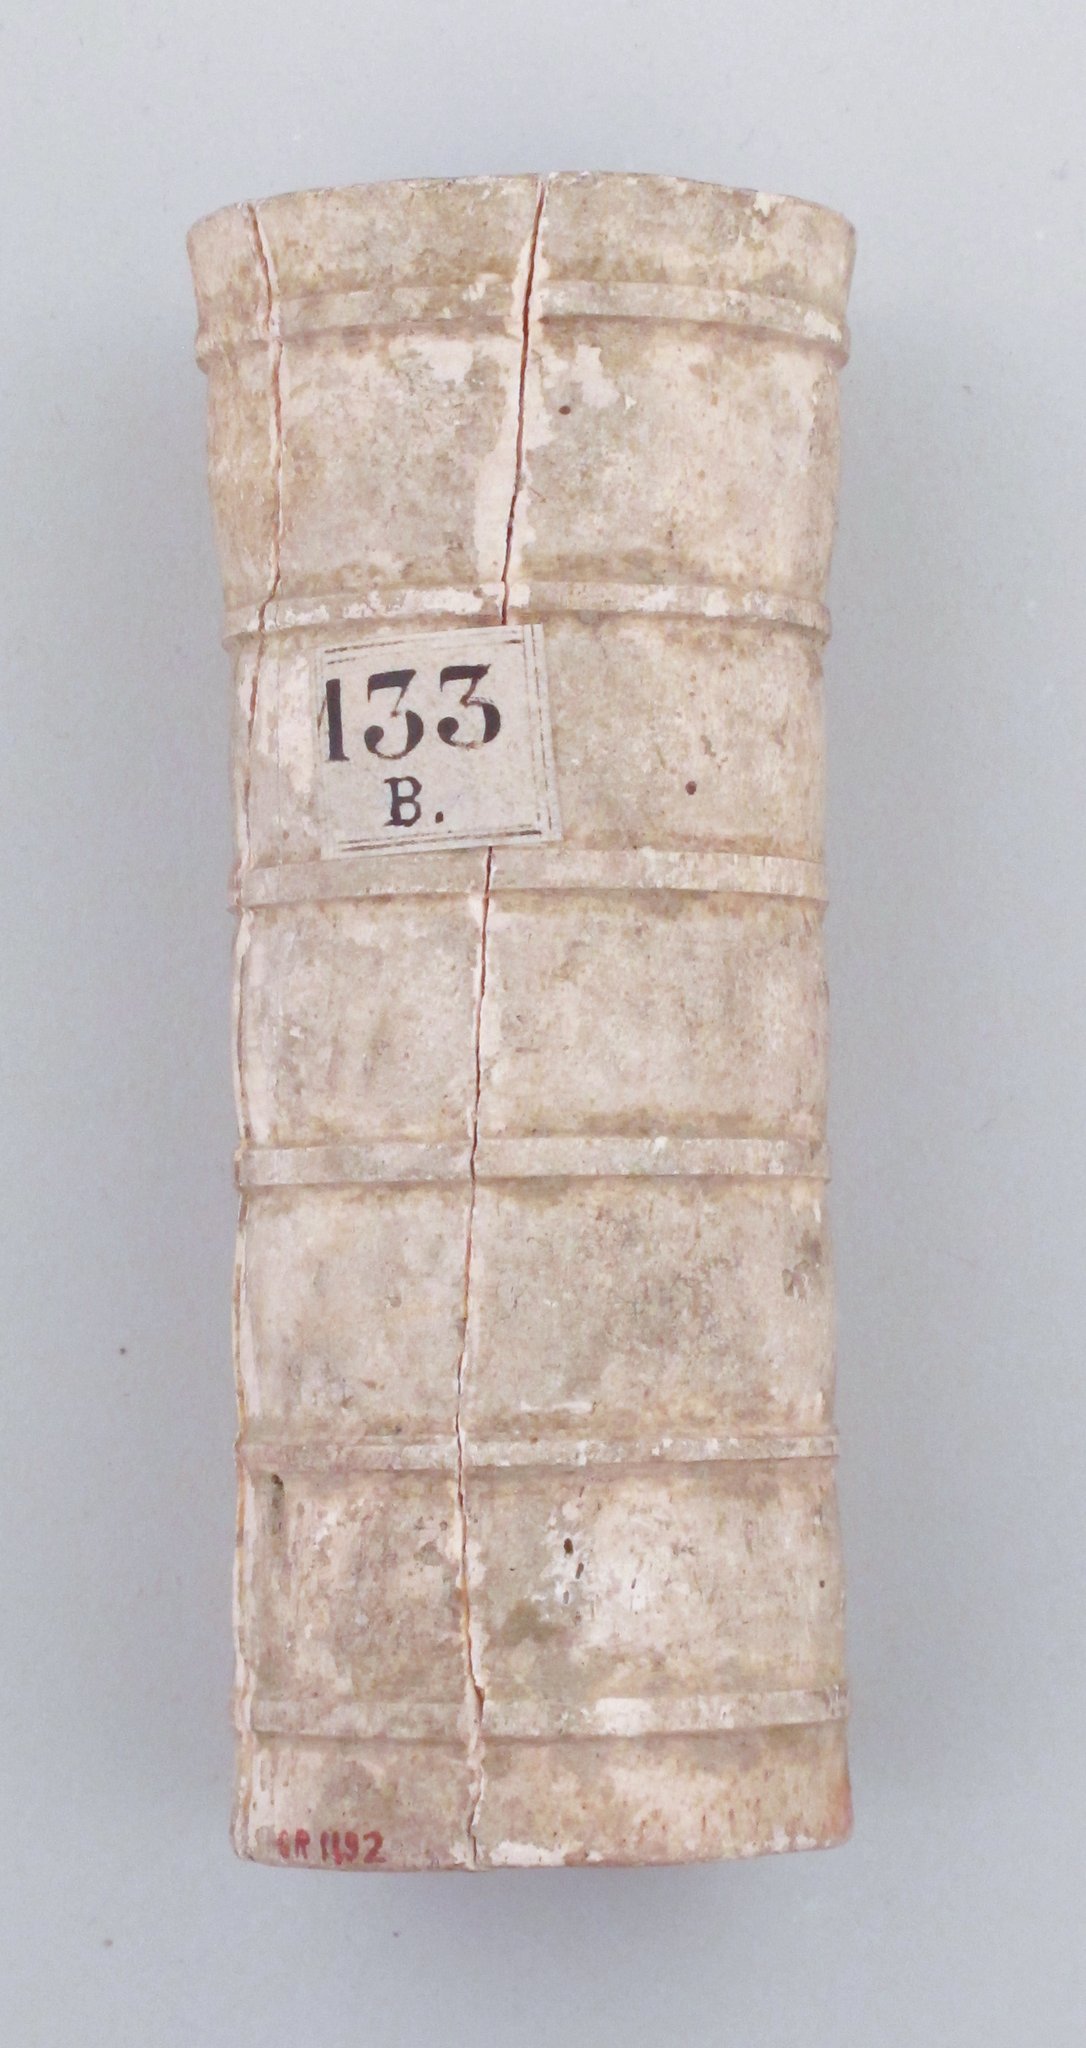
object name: handle or hollow cylinder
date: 7000 BCE-330 CE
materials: ivory